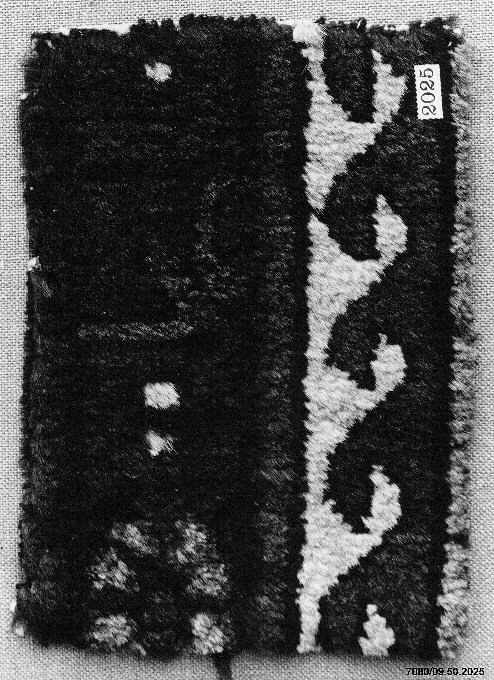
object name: carpet fragment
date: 1801-1900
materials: cotton, wool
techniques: pile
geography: northwestern iran